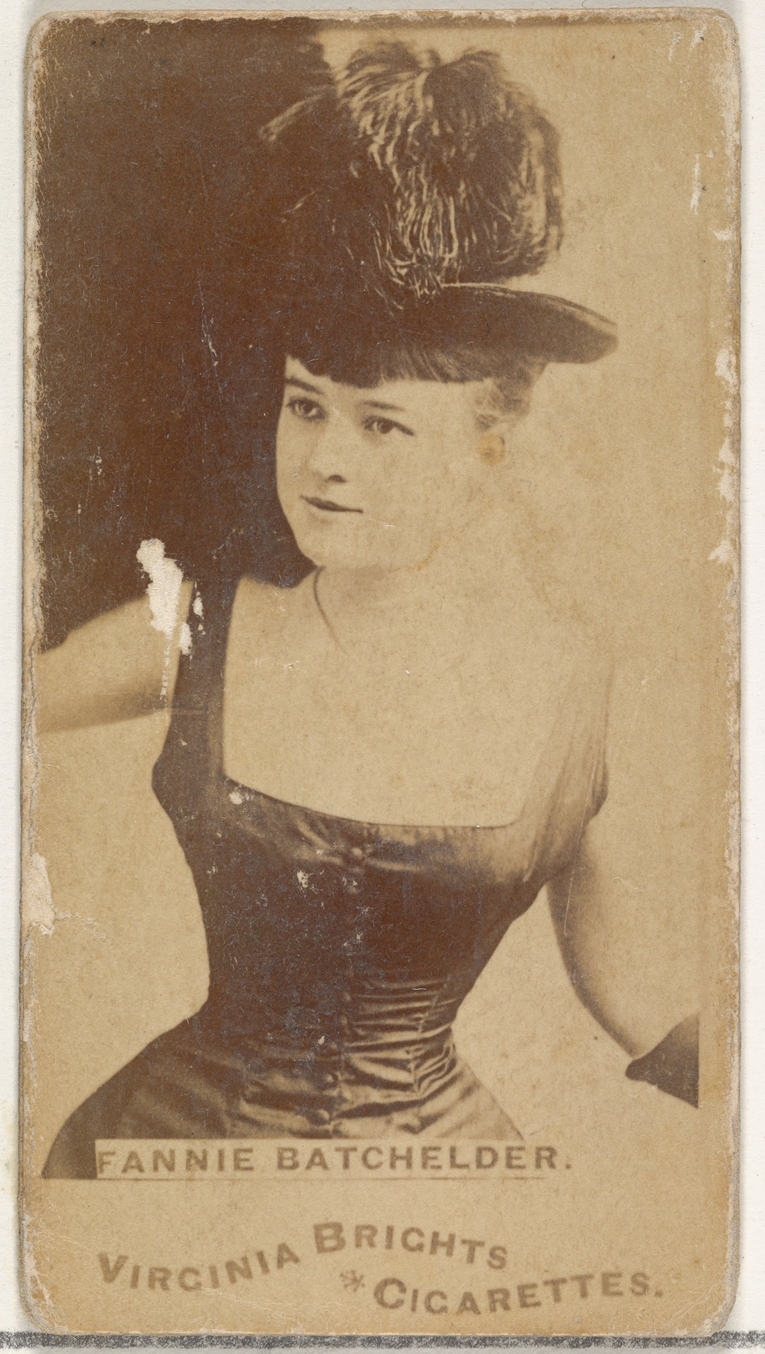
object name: photograph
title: Fannie Batchelder, from the Actors and Actresses series (N45, Type 1) for Virginia Brights Cigarettes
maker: allen & ginter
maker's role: publisher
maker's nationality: american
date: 1888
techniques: albumen silver print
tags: portraits,women,actresses